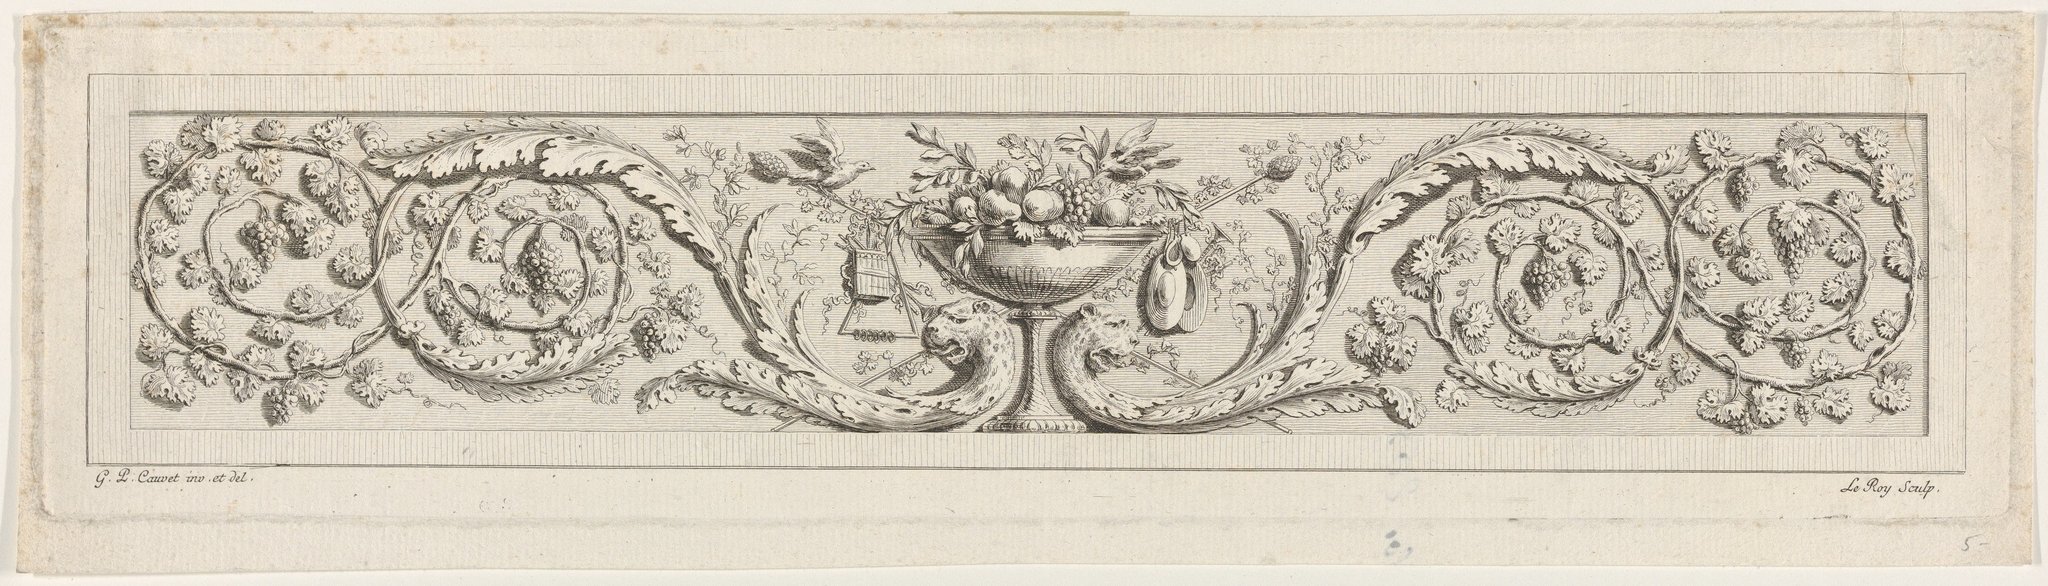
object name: print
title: Design for a Frieze with Acanthus Scrolls and a Vase in the Center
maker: gilles paul cauvet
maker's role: artist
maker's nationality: french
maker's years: 1731-1788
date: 1777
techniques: etching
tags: fruit,acanthus,vases